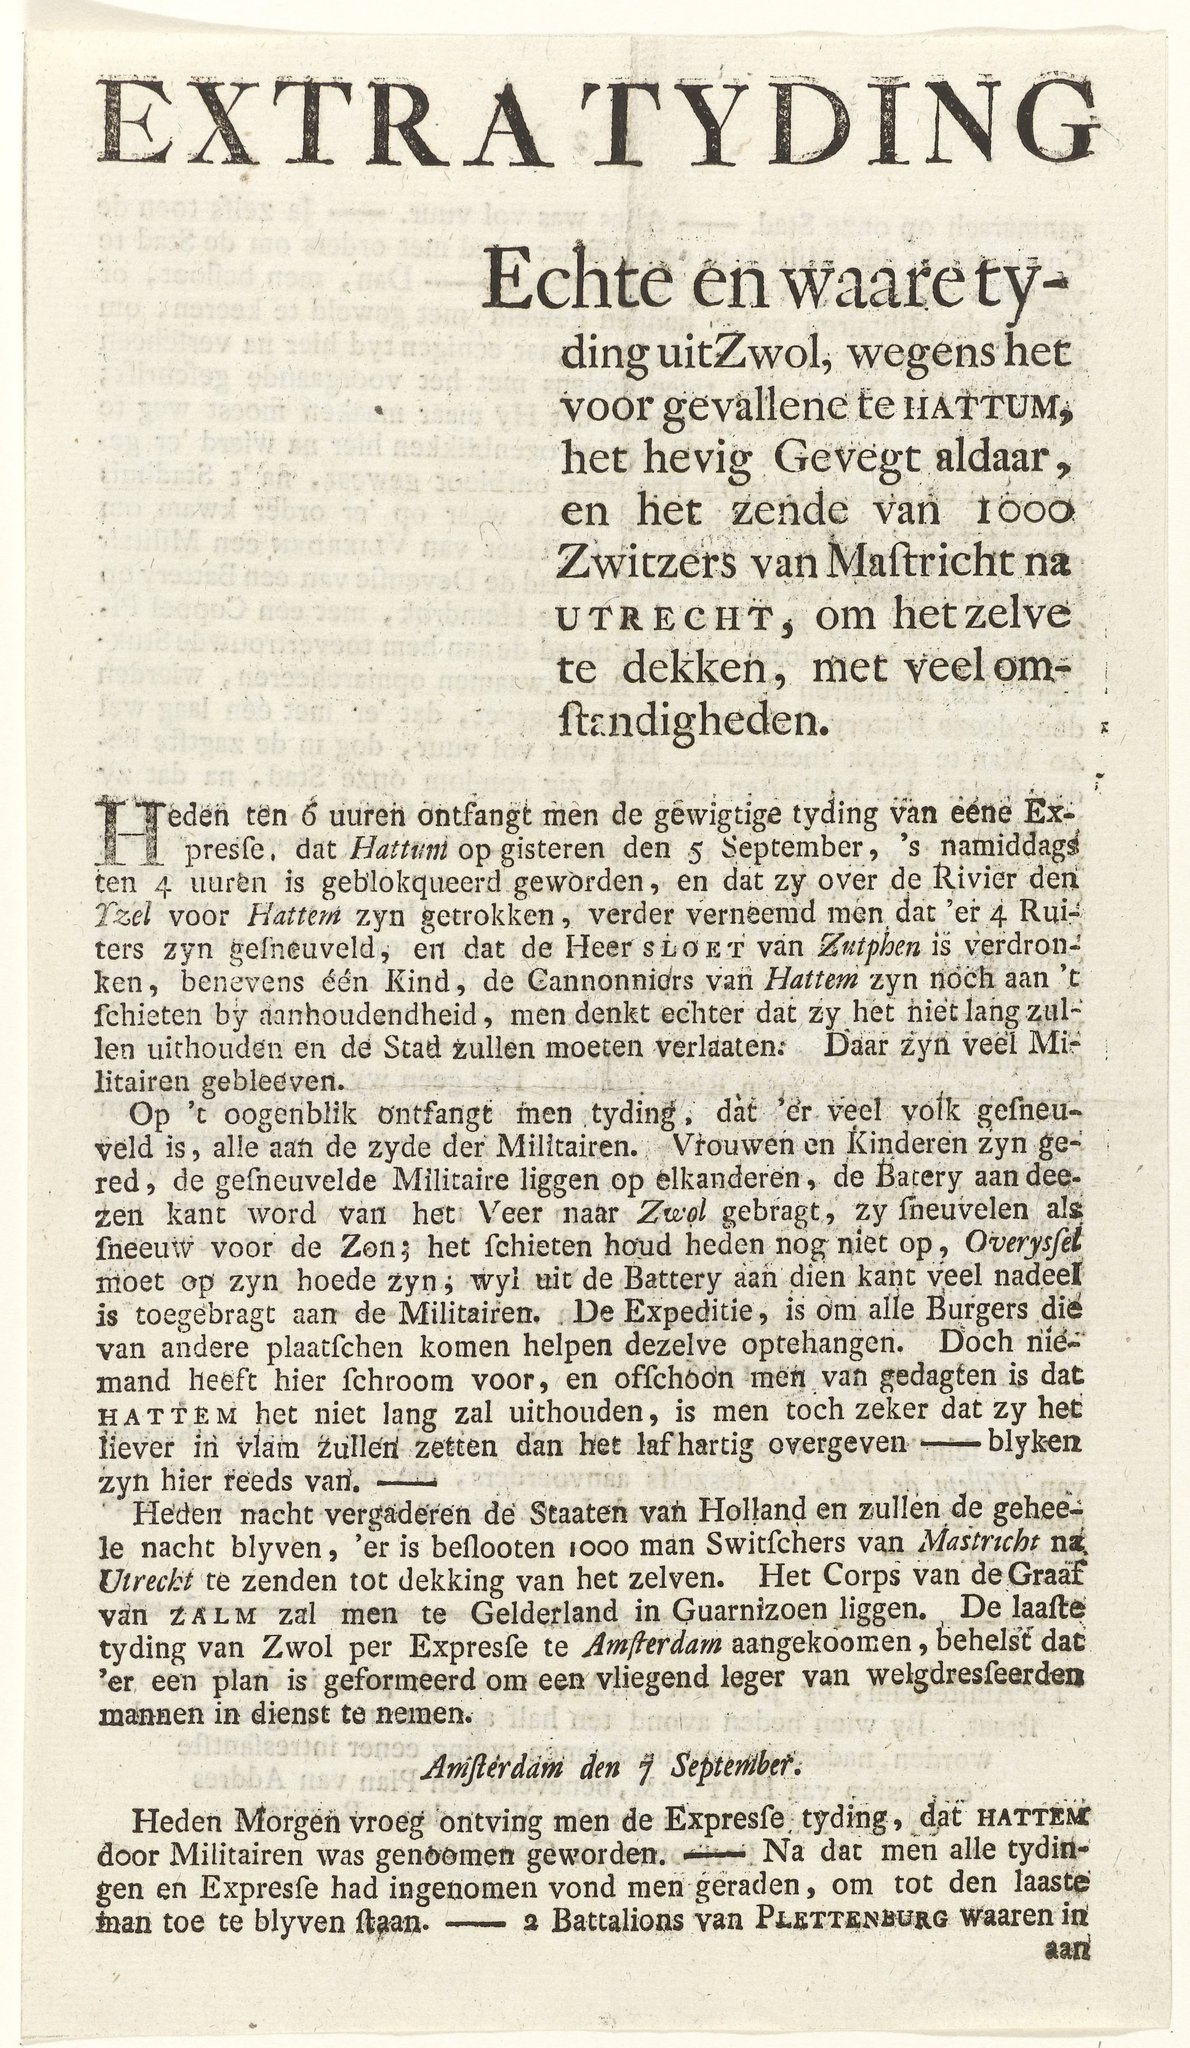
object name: text sheet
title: Extra Tyding / Echte en waare tyding uit Zwol, wegens het voor gevallende te Hattum (...)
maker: jan verlem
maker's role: publisher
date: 1786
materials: paper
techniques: letterpress printing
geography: amsterdam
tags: hattem, aanval op hattem en elburg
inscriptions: collector's mark: Lugt 2228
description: Patriots nieuwsbericht van 7 september over de beschieting van Hattem door de stadhouderlijke troepen op 5 september 1786. Blad bedrukt op beide zijden.